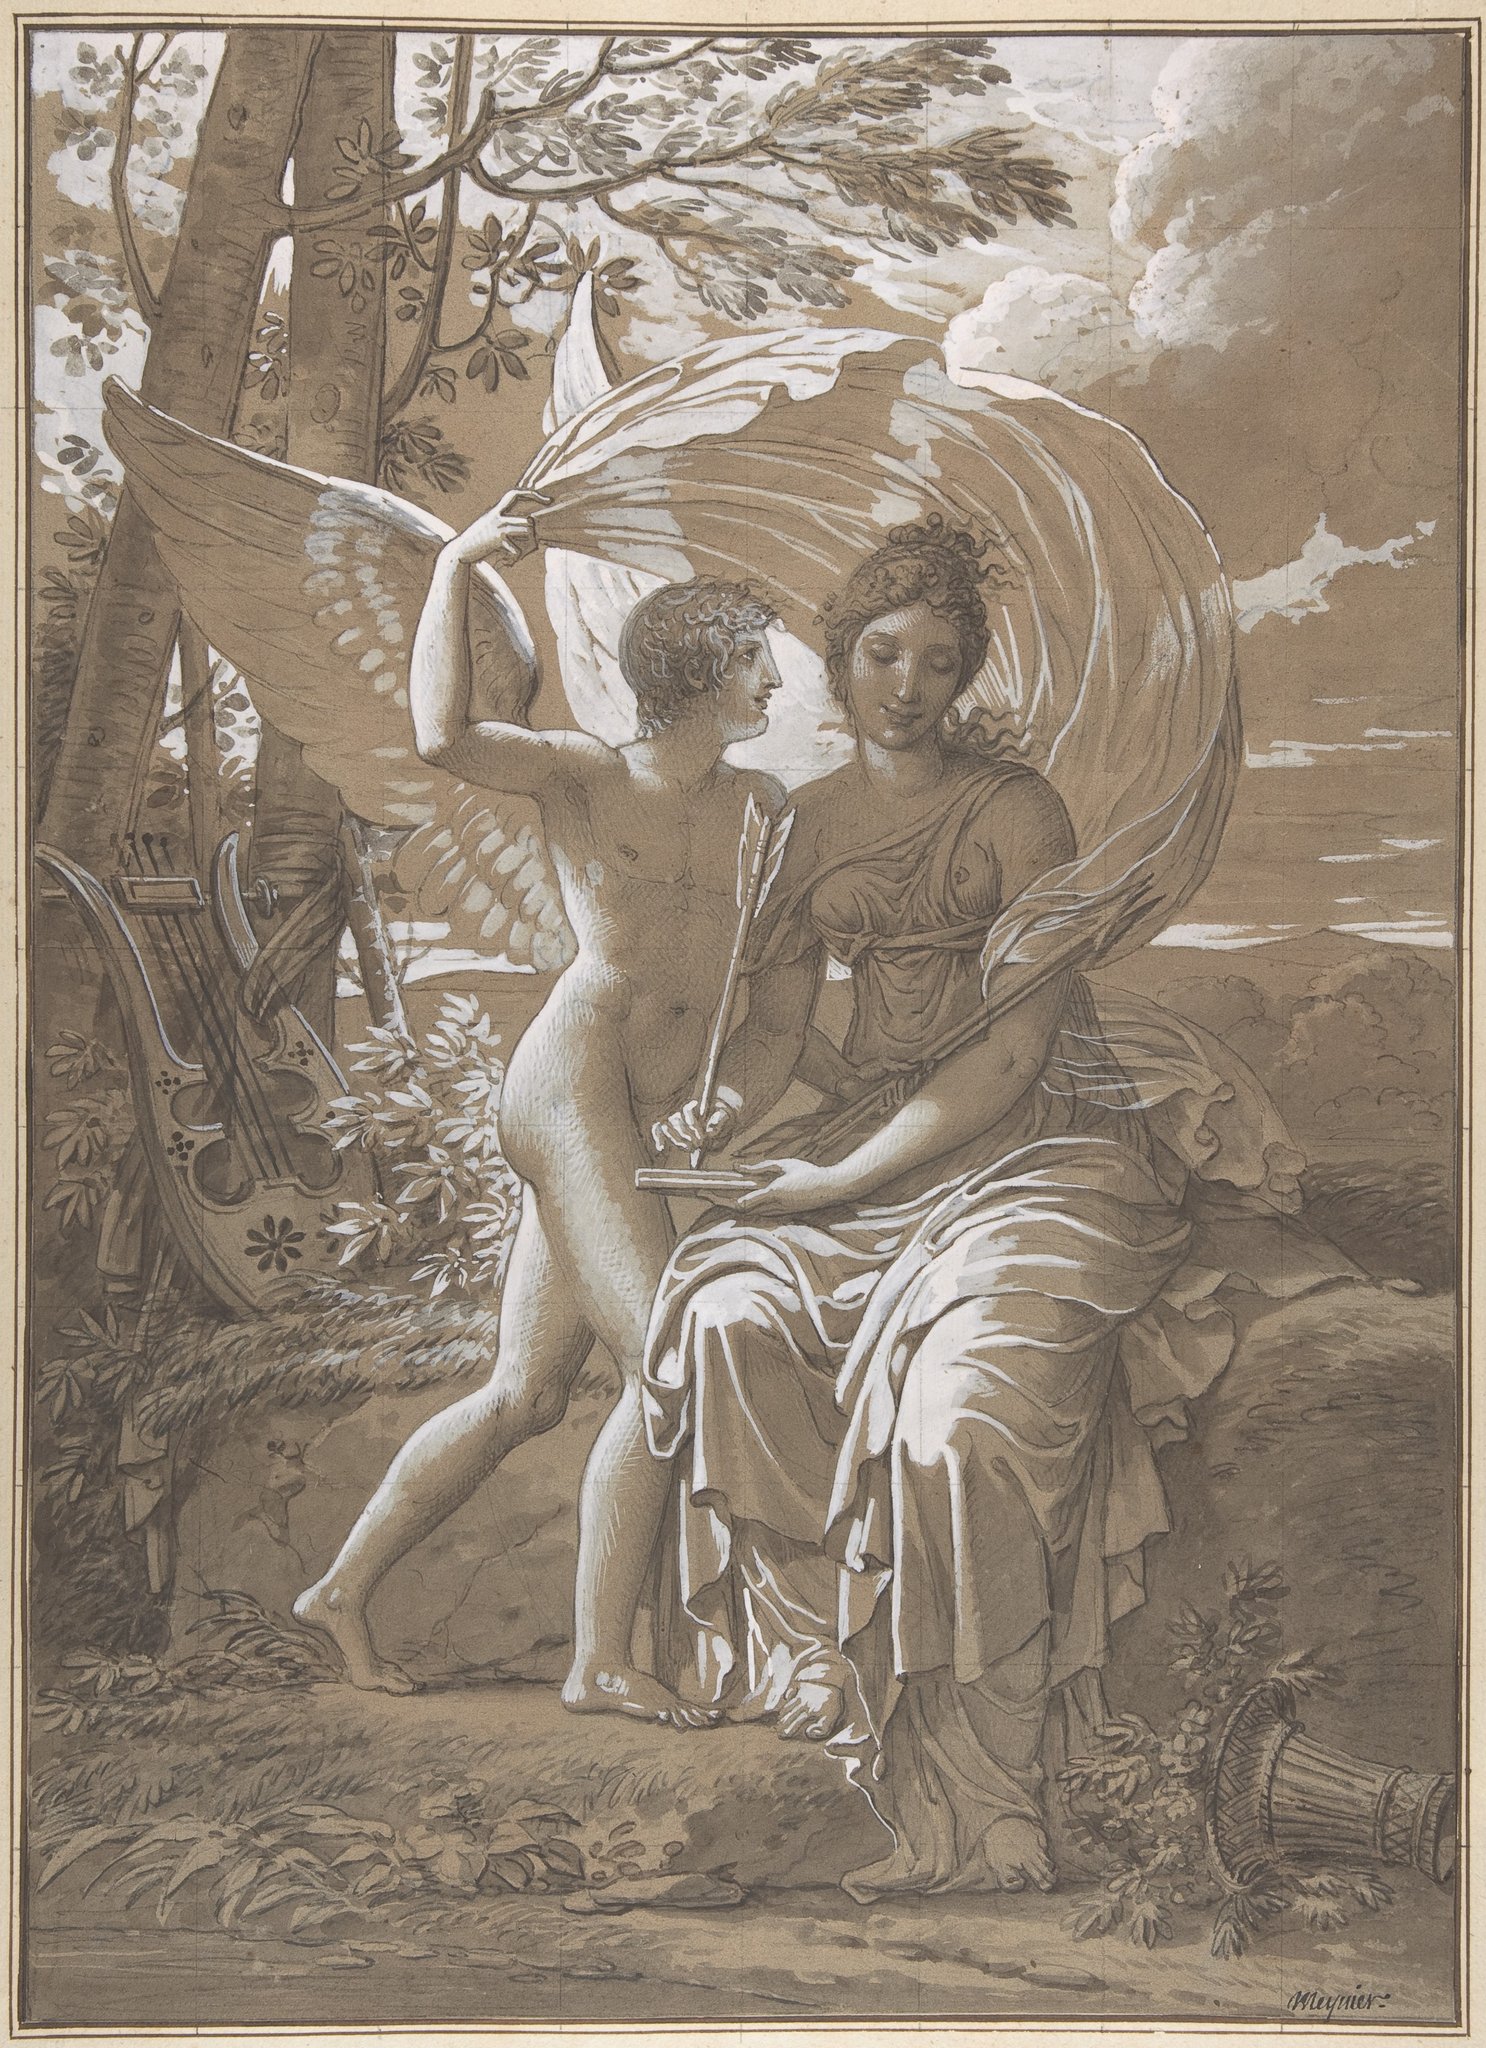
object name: drawing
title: The Muse Erato Writing Verses Inspired by Love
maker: charles meynier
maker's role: artist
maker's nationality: french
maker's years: 1768-1832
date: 1797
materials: chalk, gouache, ink, paper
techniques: brush, heightening, pen, drawing, wash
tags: musical instruments,poetry,love,muses